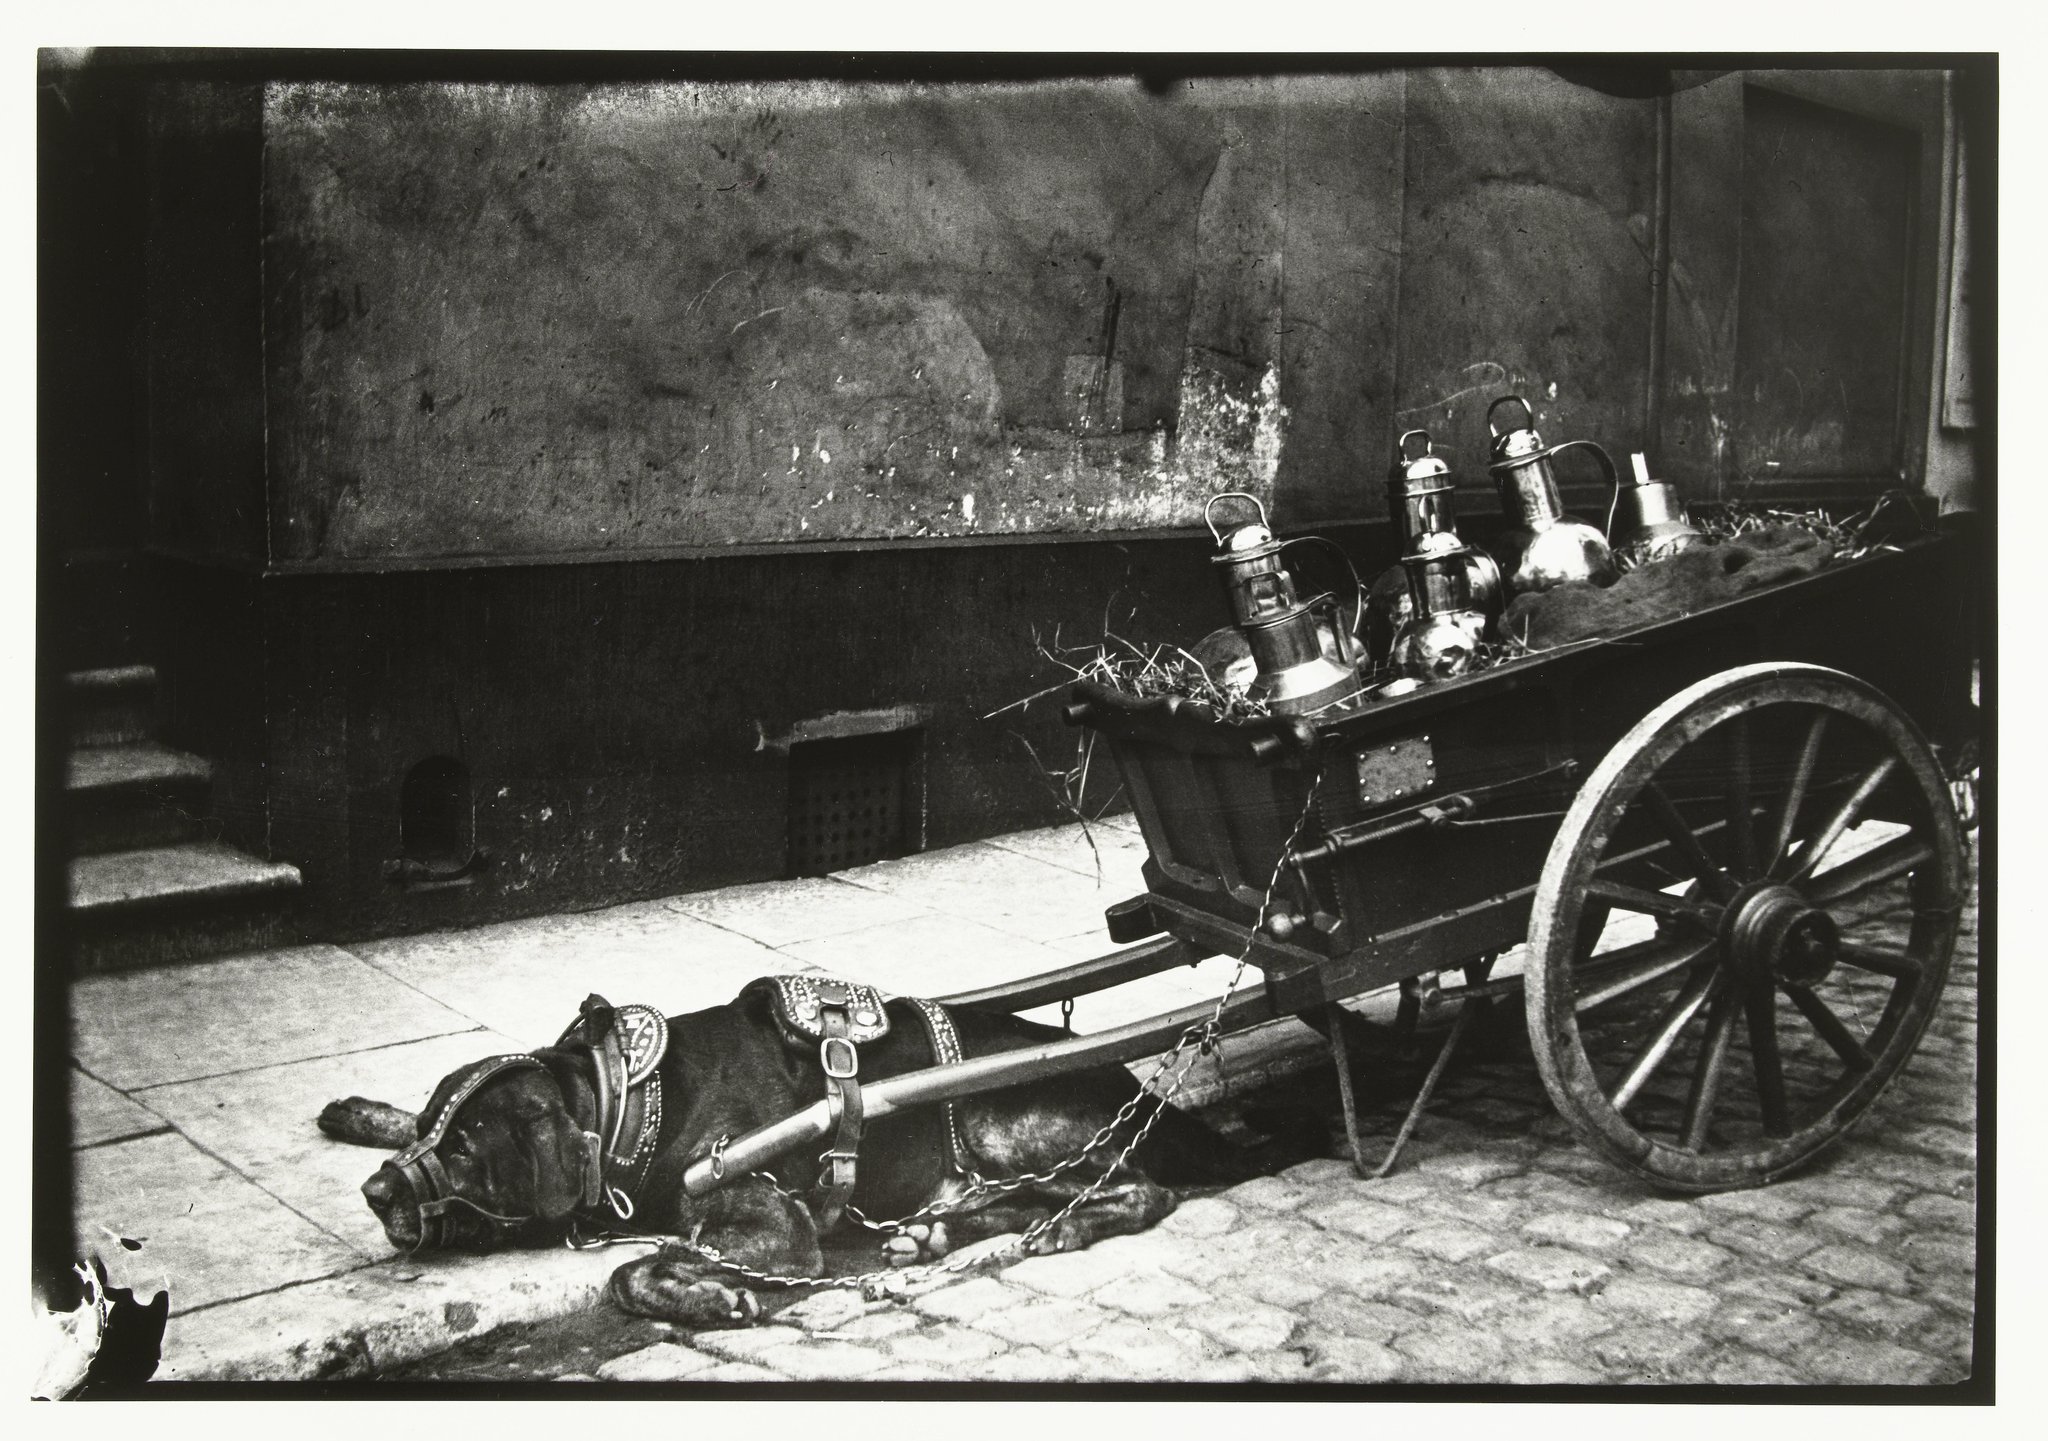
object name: photograph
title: Trekhond voor een kar met bussen gespannen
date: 1890-1910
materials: paper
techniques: gelatin silver print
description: Moderne afdruk van negatief BR 398 (collectie RKD).